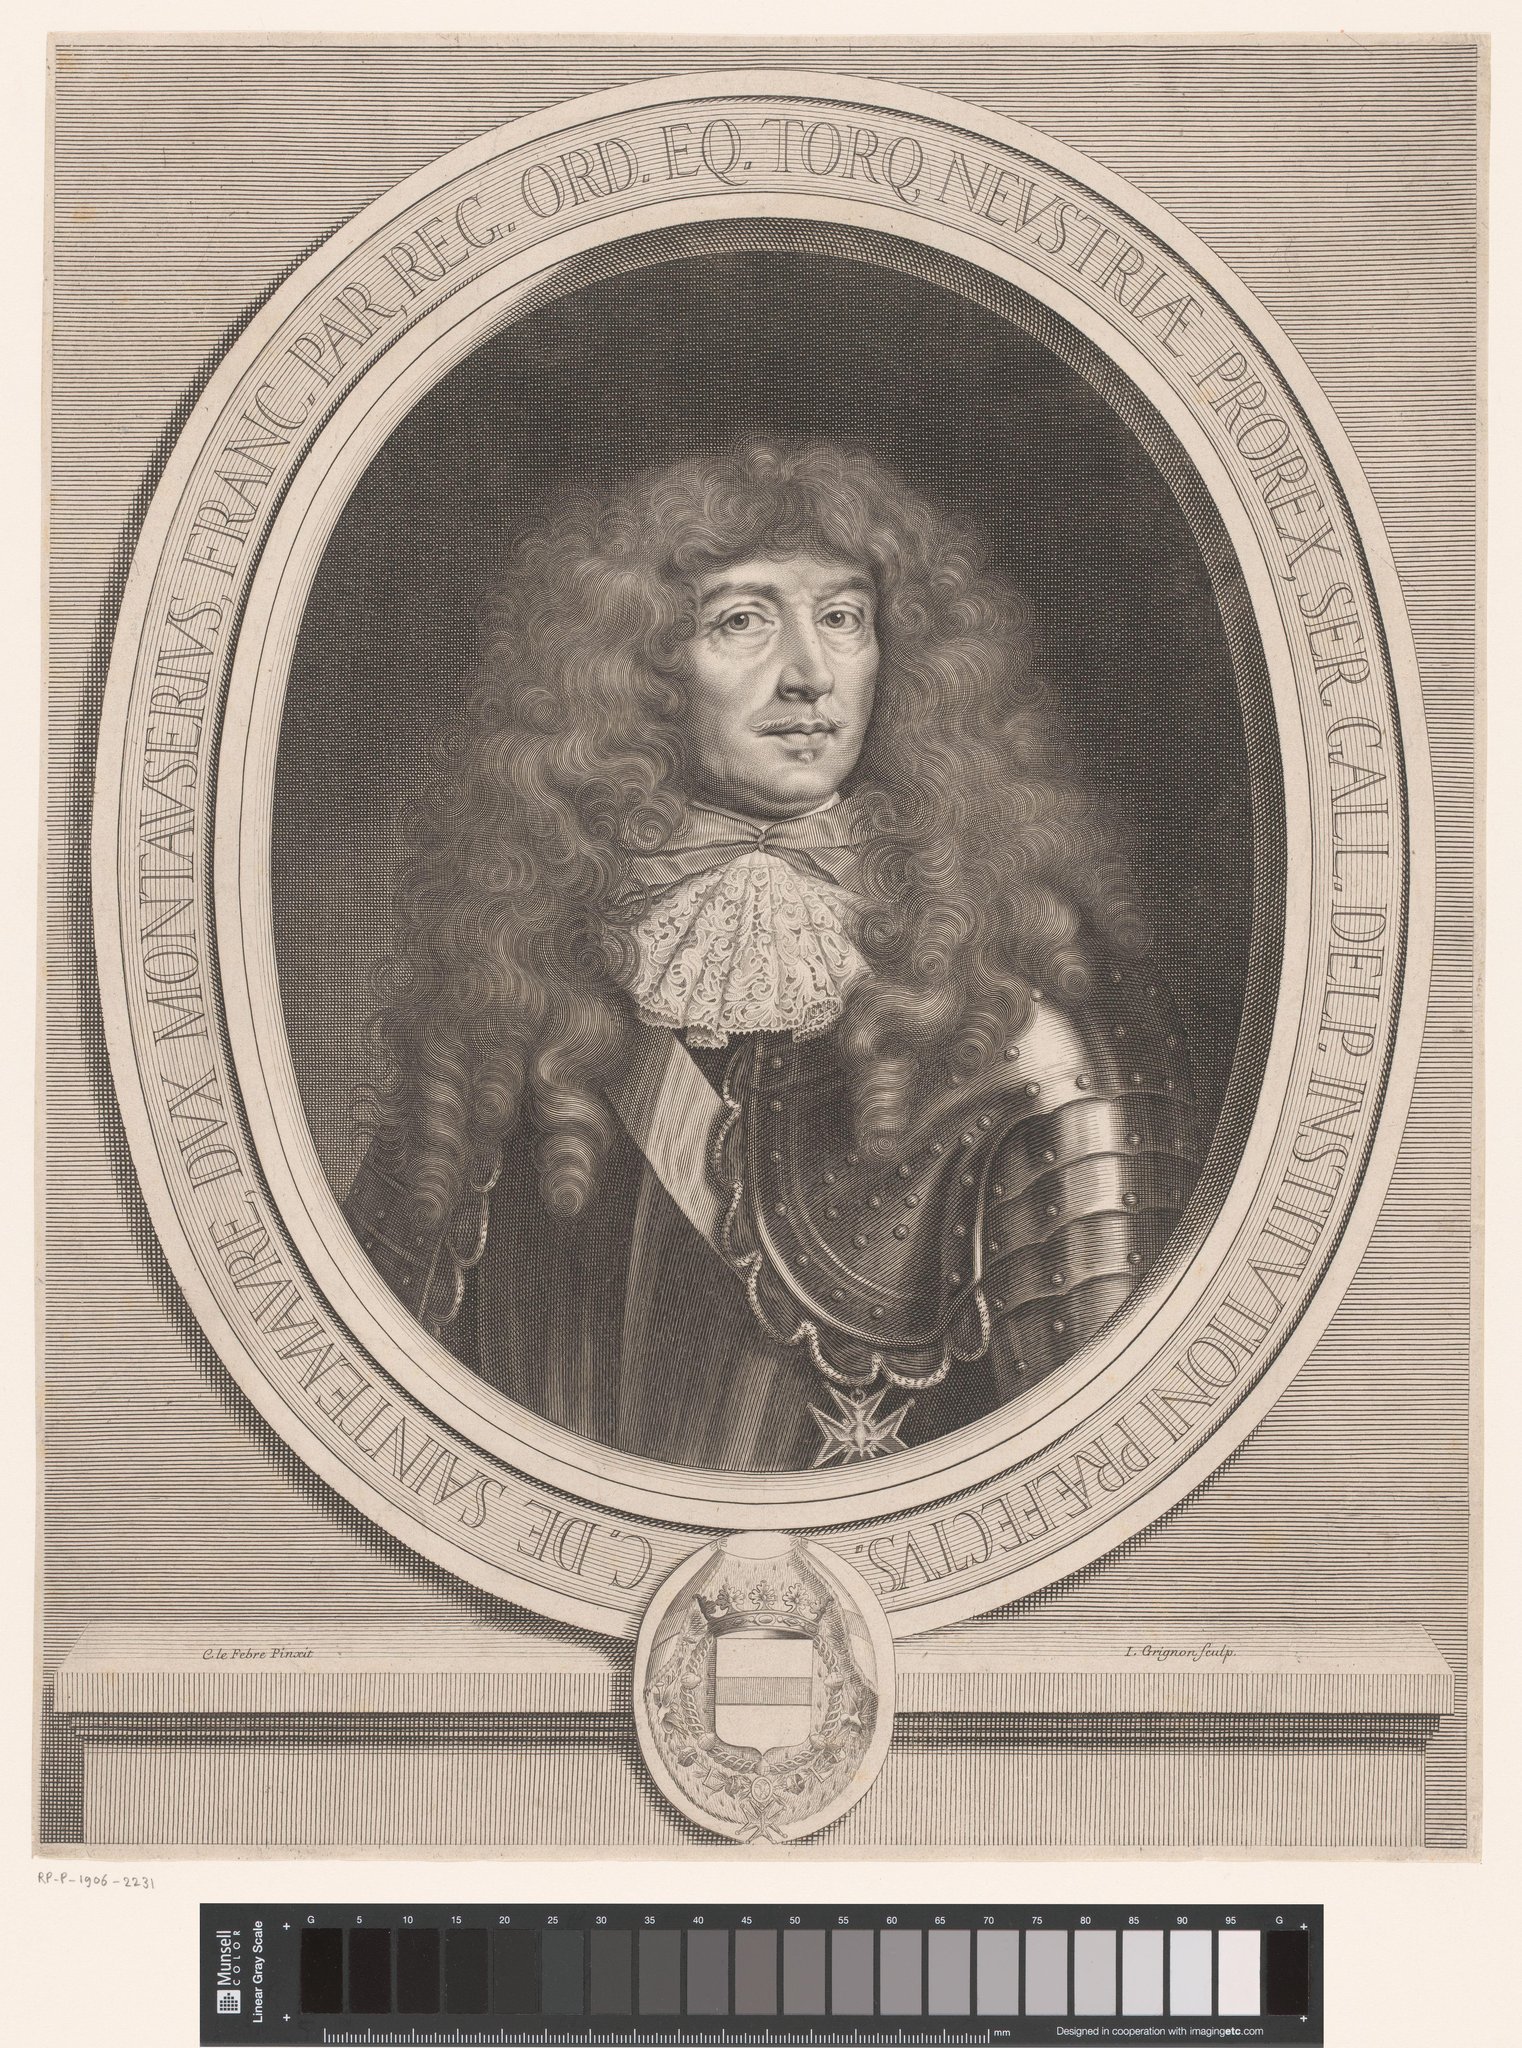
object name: print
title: Portret van Charles de Sainte-Maure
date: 1650-1689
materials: paper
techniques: engraving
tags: historical persons, armorial bearing, heraldry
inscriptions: collector's mark: Lugt 2228